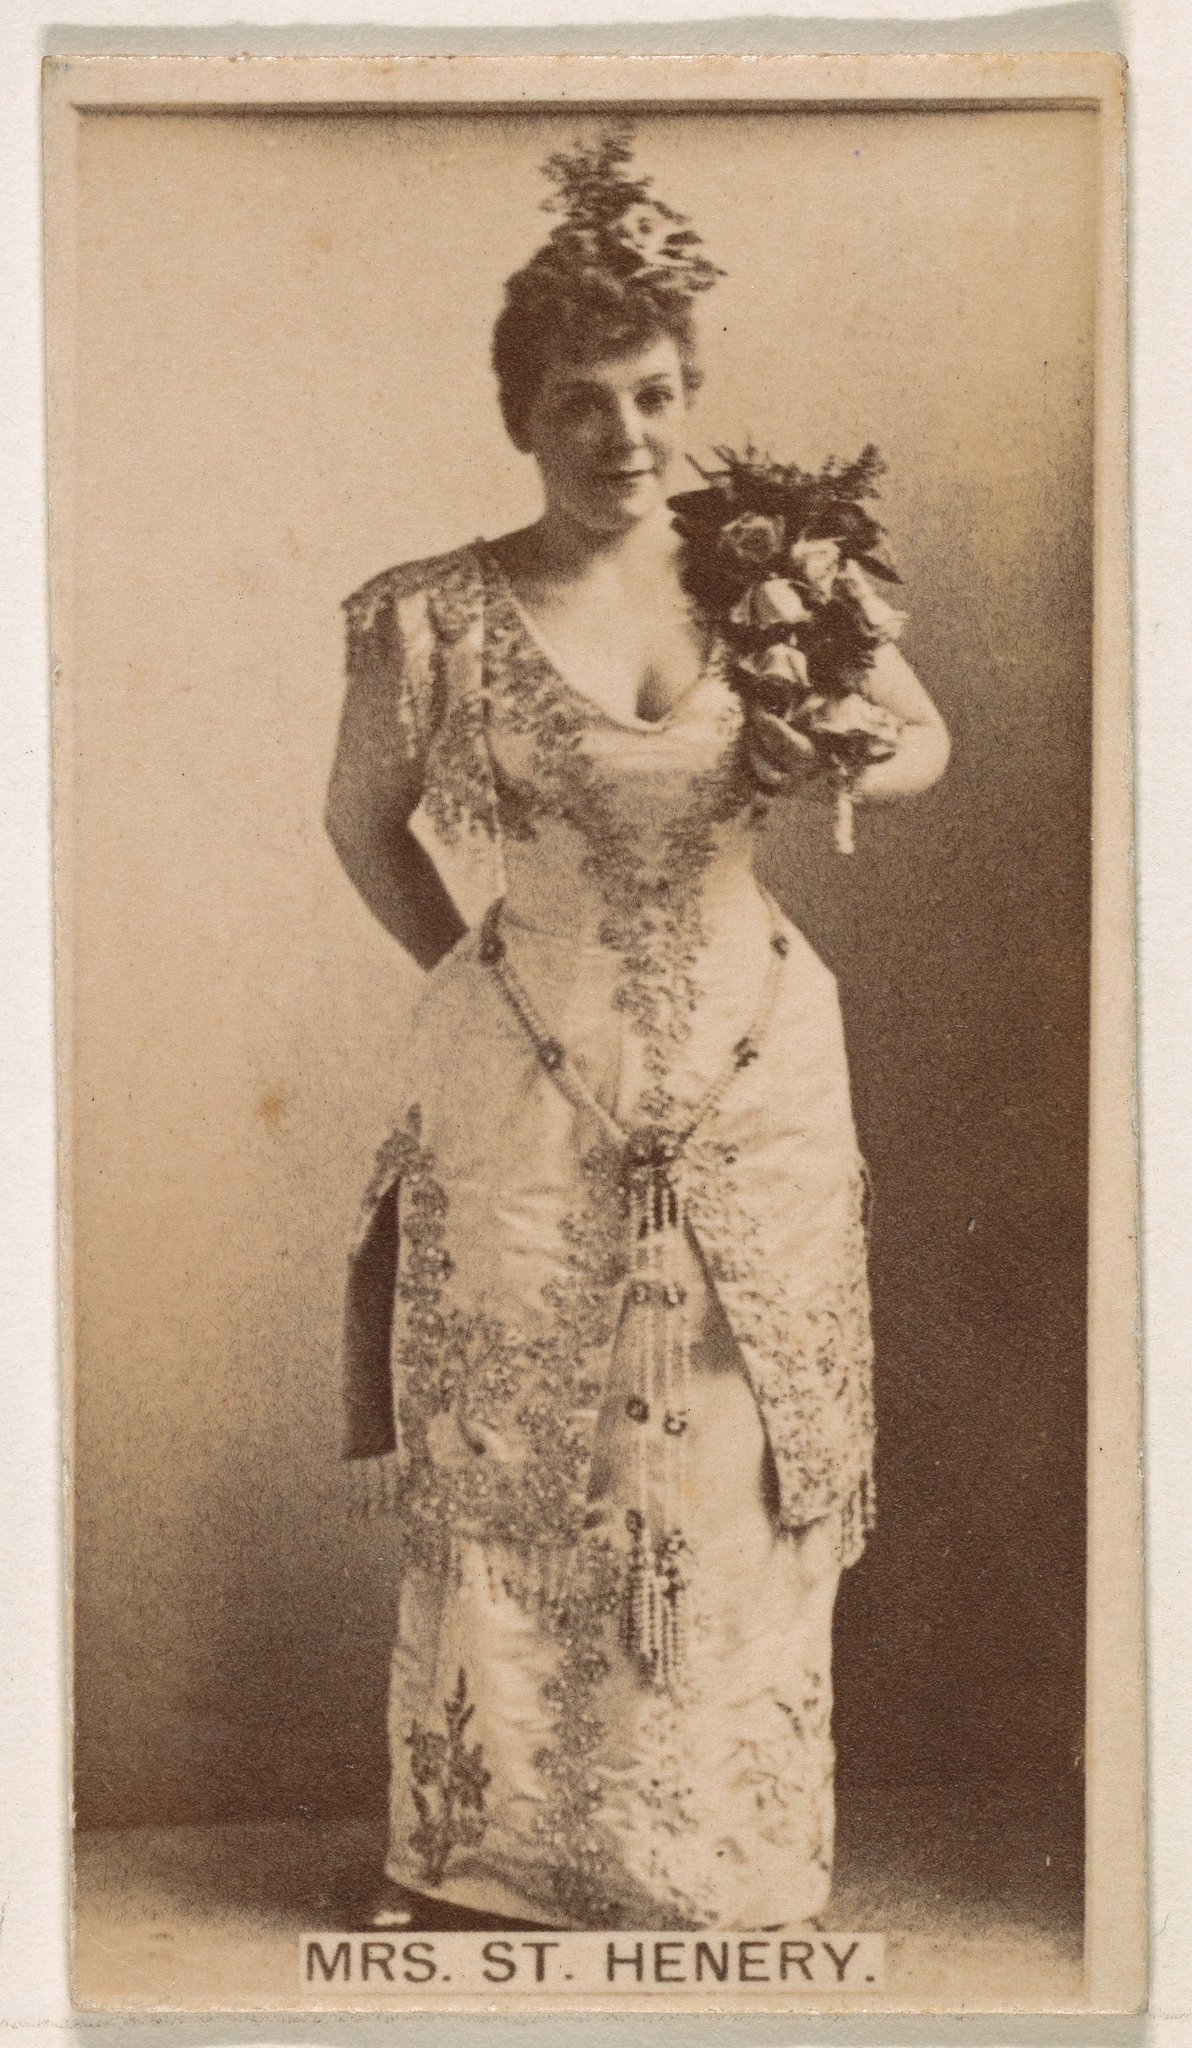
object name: photograph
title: Mrs. St. Henery, from the Actresses series (N245) issued by Kinney Brothers to promote Sweet Caporal Cigarettes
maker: kinney brothers tobacco company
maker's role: publisher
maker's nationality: american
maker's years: 1869-2011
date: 1890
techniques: albumen silver print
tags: portraits,women,actresses